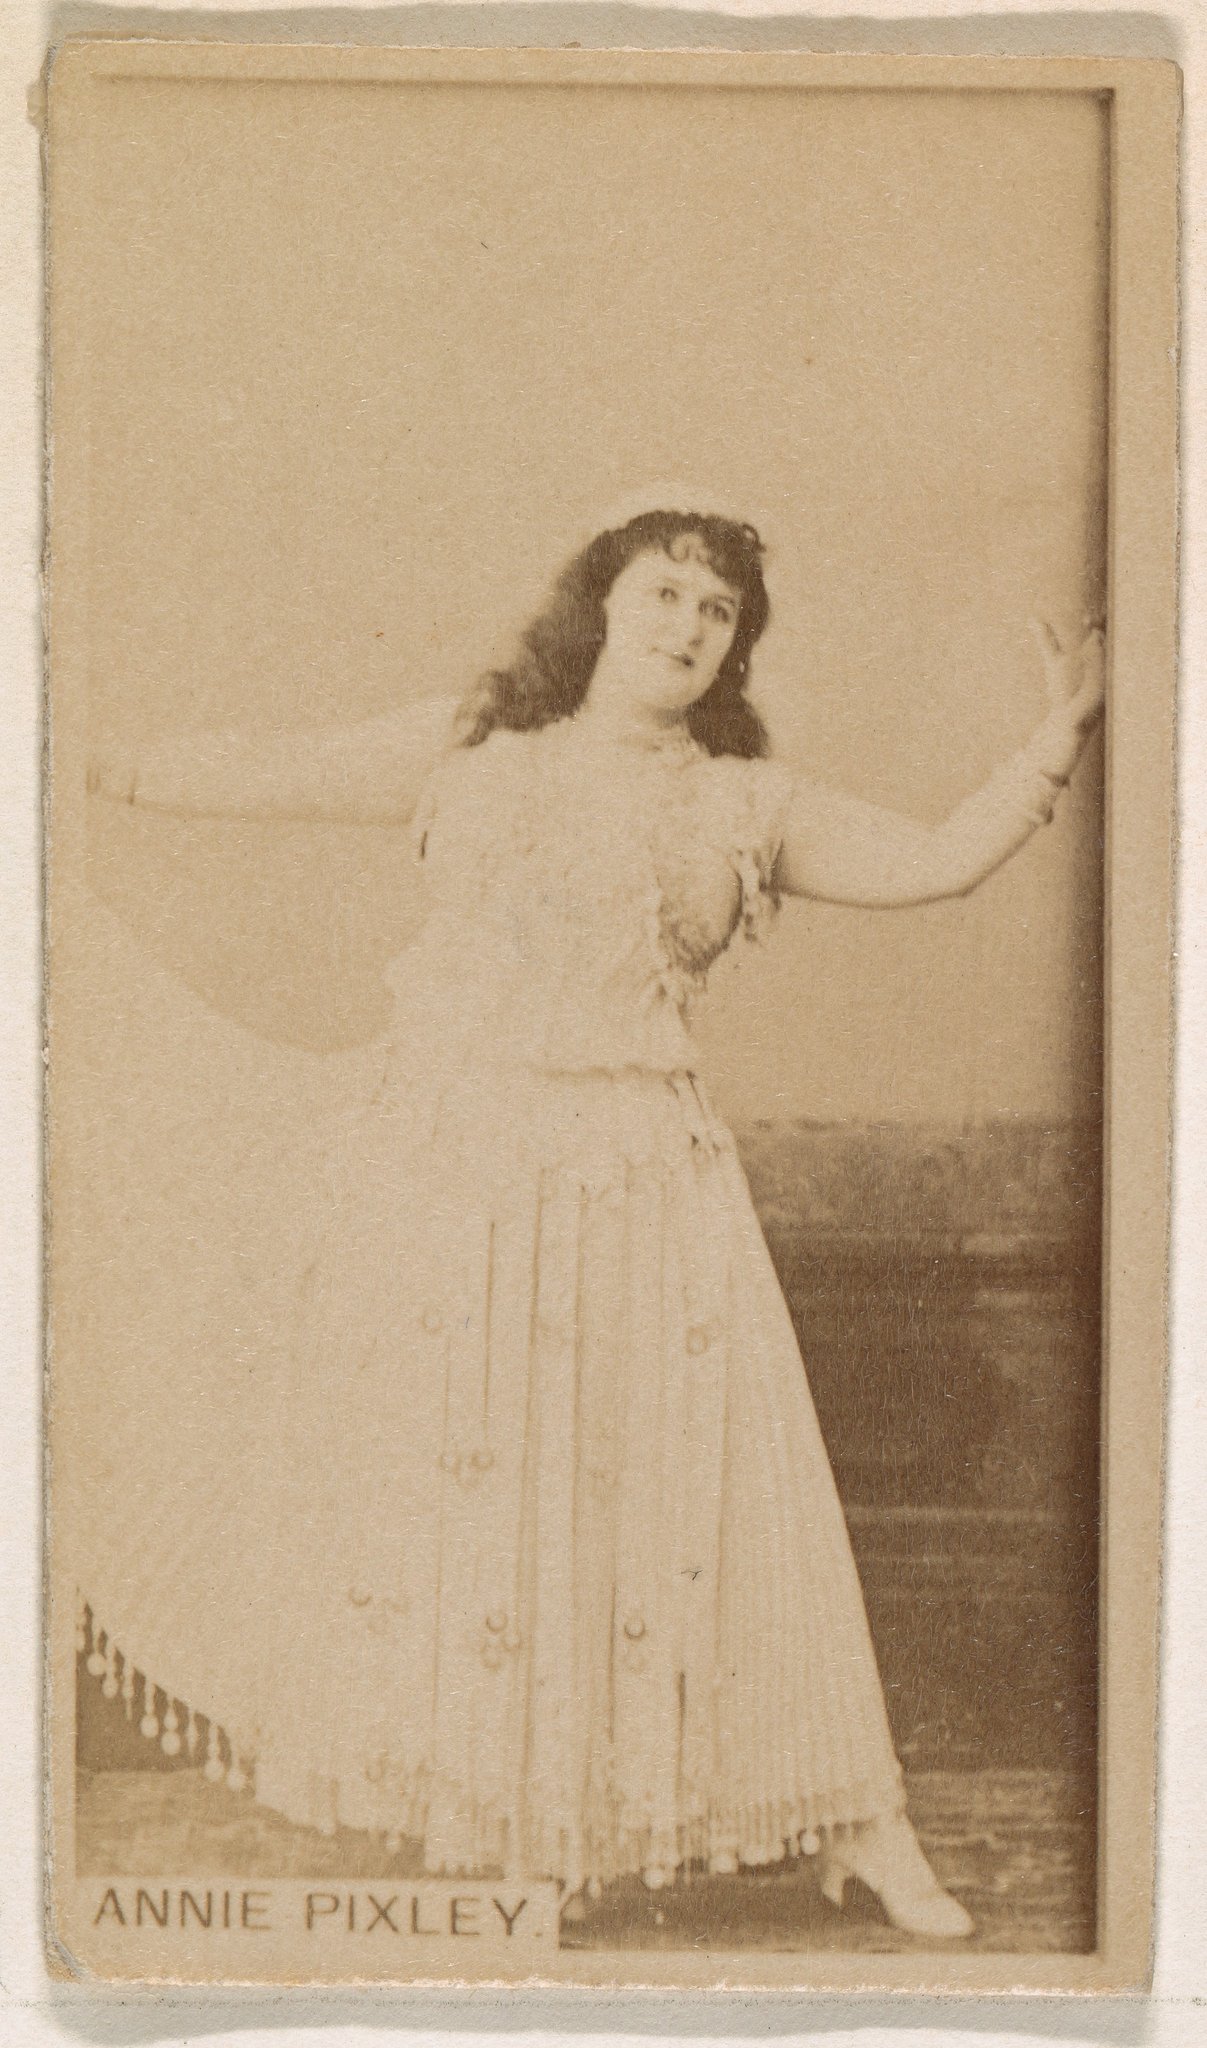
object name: photograph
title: Annie Pixley, from the Actresses series (N245) issued by Kinney Brothers to promote Sweet Caporal Cigarettes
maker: kinney brothers tobacco company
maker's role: publisher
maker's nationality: american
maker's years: 1869-2011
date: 1890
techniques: albumen silver print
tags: portraits,women,actresses